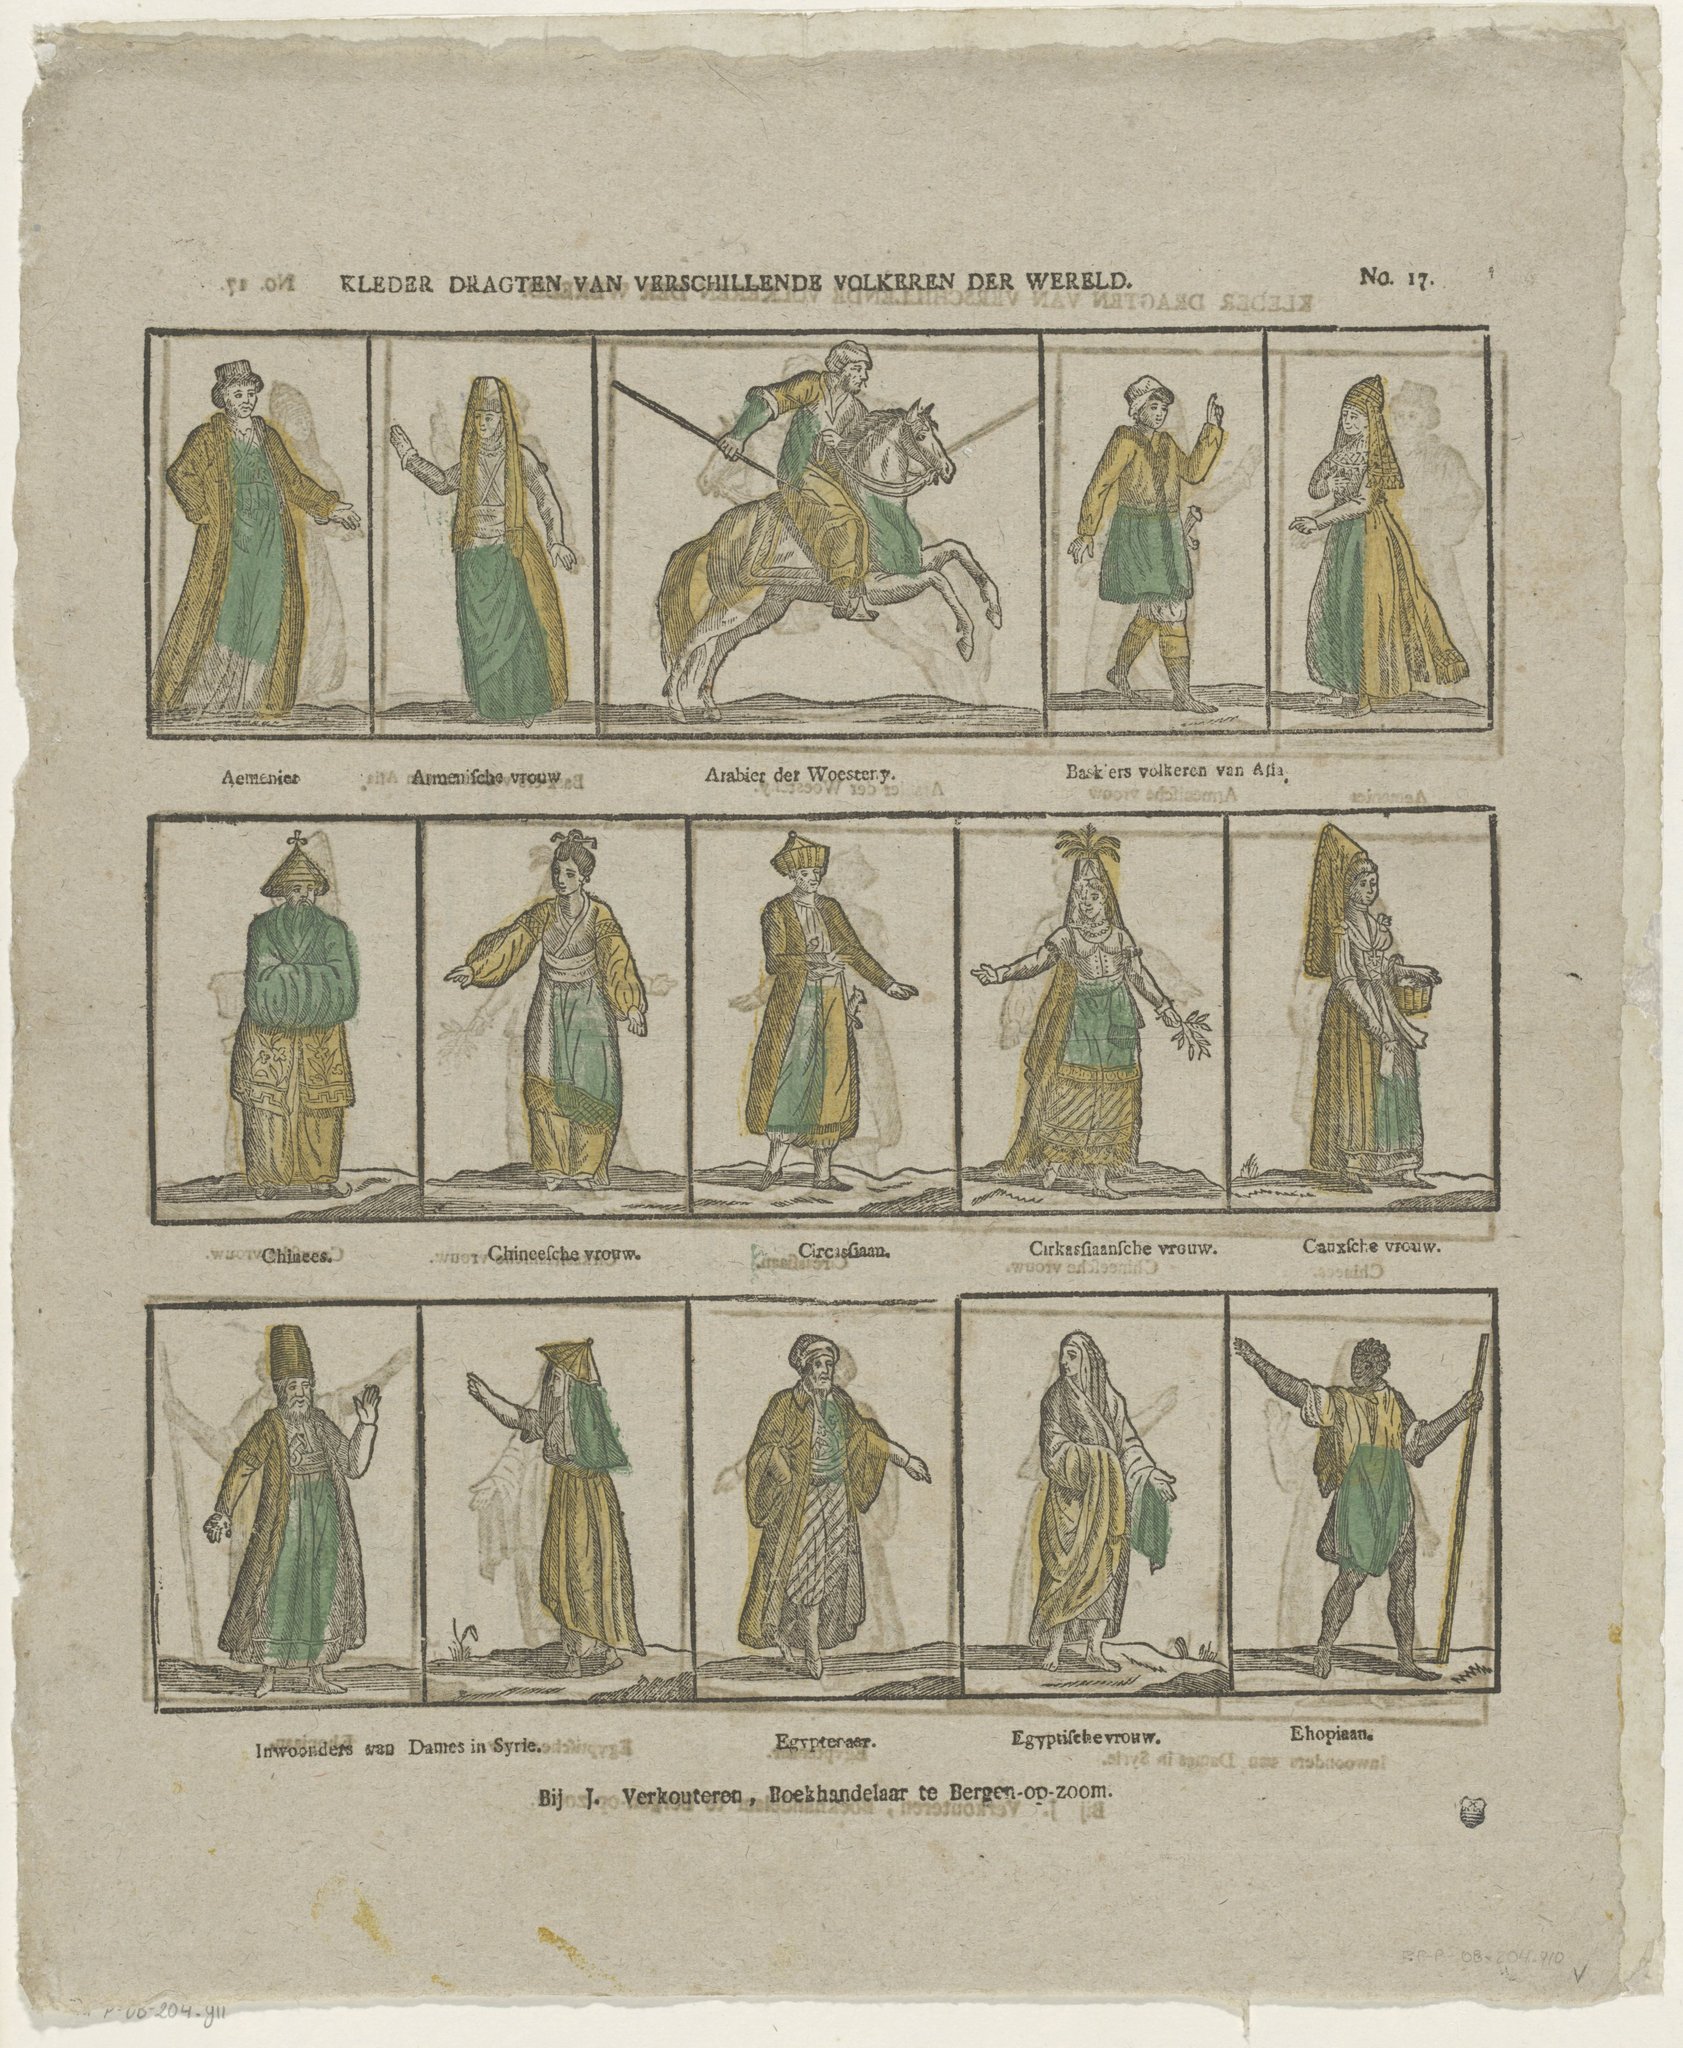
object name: popular print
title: kleder-dragten van verschillende volkeren der wereld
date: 1806-1830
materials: paper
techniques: colour, letterpress printing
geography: netherlands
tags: asiatic races and peoples, africans, historical costume, folk costume, regional costume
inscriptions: collector's mark: Lugt 2760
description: Blad met 3 houtsneden met elk vijf voorstellingen van klederdrachten van verschillende volkeren, waaronder klederdracht uit China en Egypte. Onder elke voorstelling een onderschrift. Genummerd rechtsboven: No. 17.